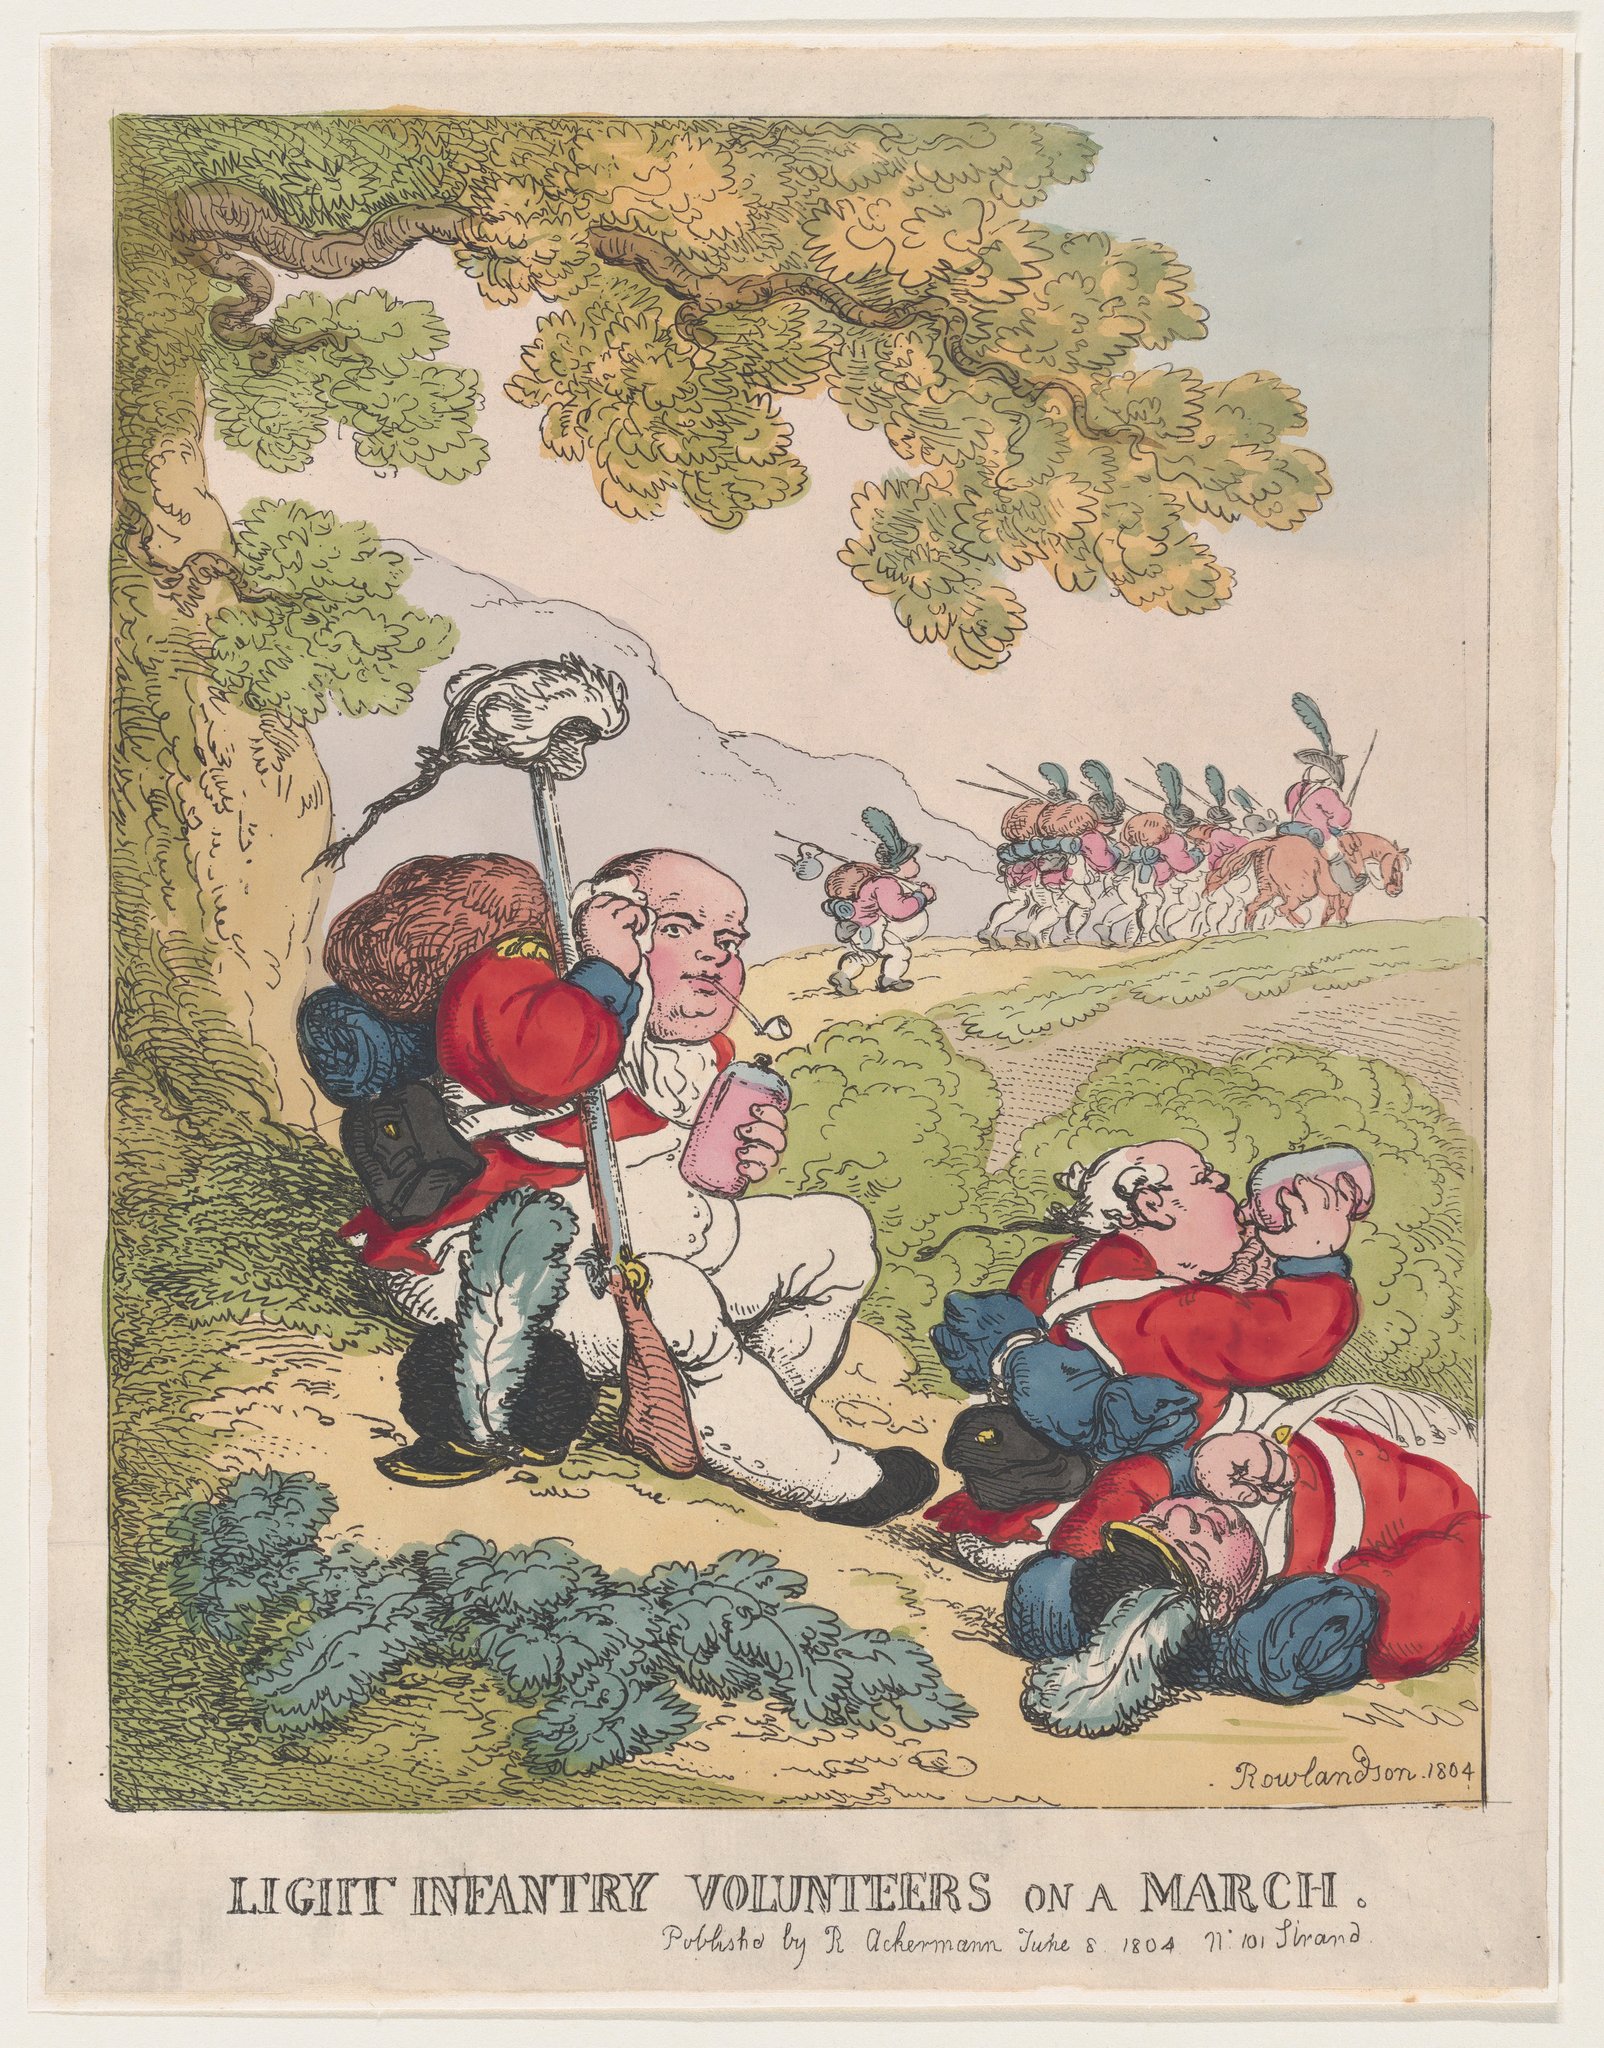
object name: print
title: Ligit Infantry Volunteers on a March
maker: thomas rowlandson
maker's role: artist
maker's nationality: british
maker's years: 1757-1827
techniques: etching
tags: satire,soldiers,men,smoking,drinking